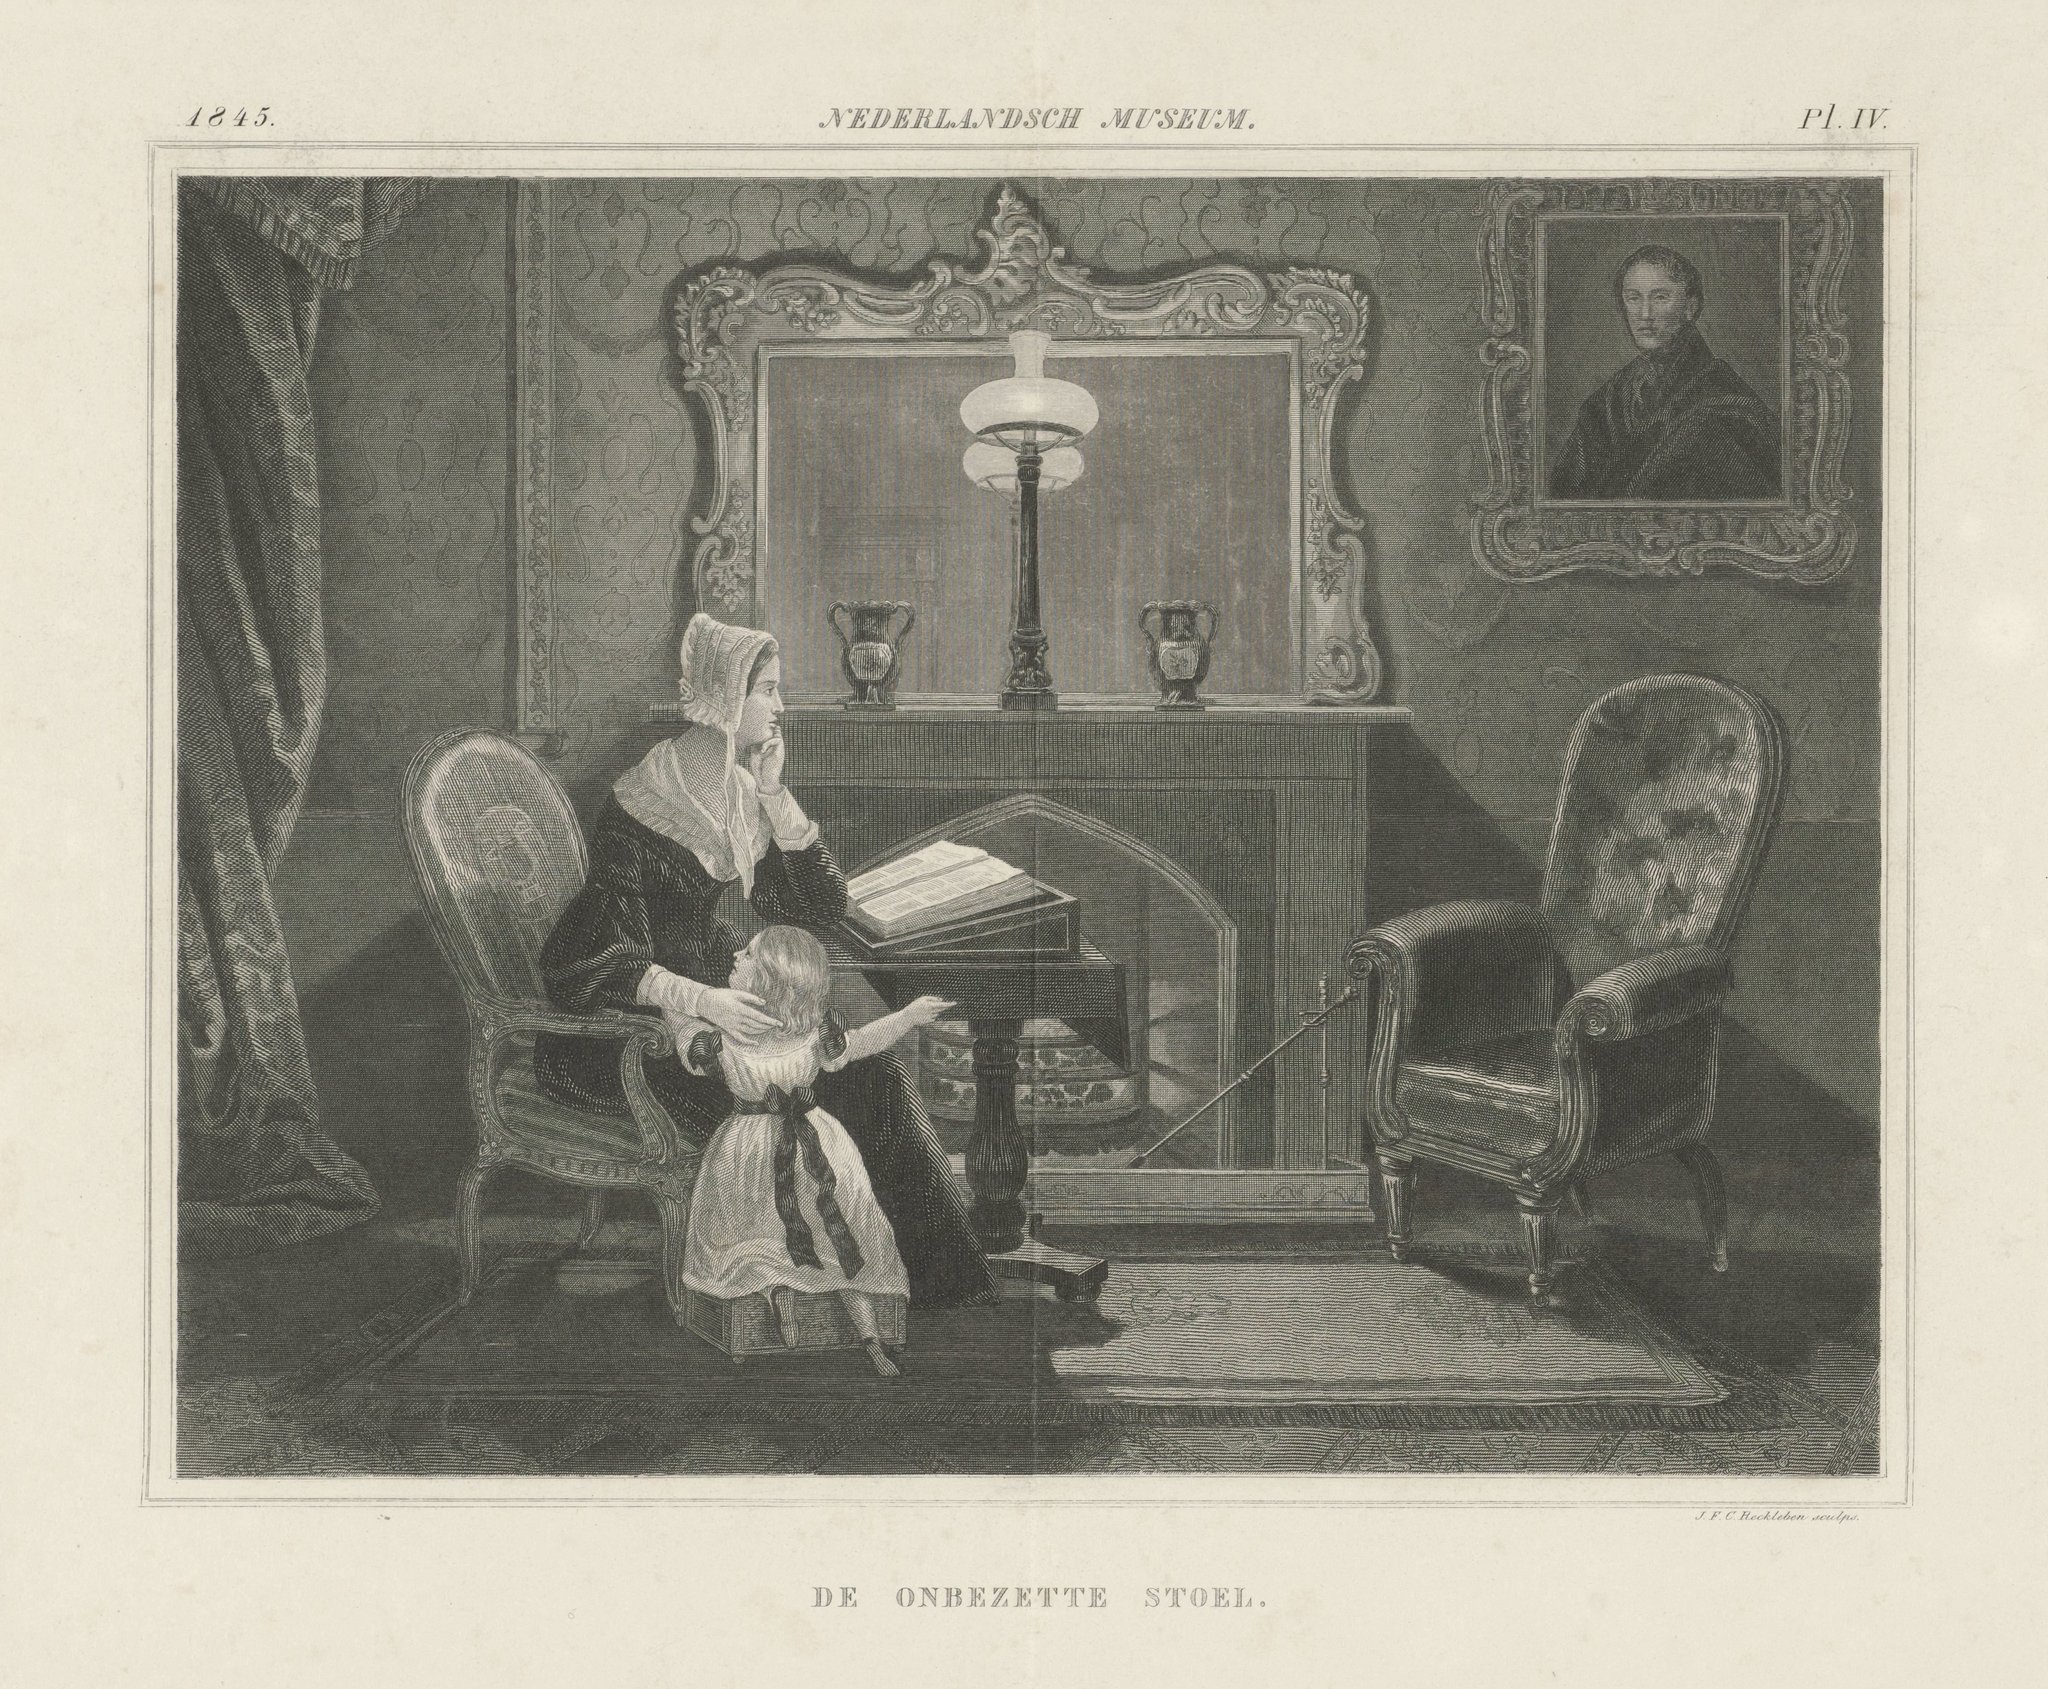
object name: print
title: De onbezette stoel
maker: jan frederik christiaan reckleben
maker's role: print maker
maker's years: 1819-1879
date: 1845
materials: paper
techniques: engraving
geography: amsterdam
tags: chimney, picture, painting, mother and child(ren), woman and child(ren) (family group)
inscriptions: collector's mark: Lugt 2228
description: In een vertrek zit een vrouw bij de open haard achter een lessenaar. Bij haar staat een kind dat wijst op de lege stoel tegenover de vrouw. Boven de lege stoel hangt een portret van een man.